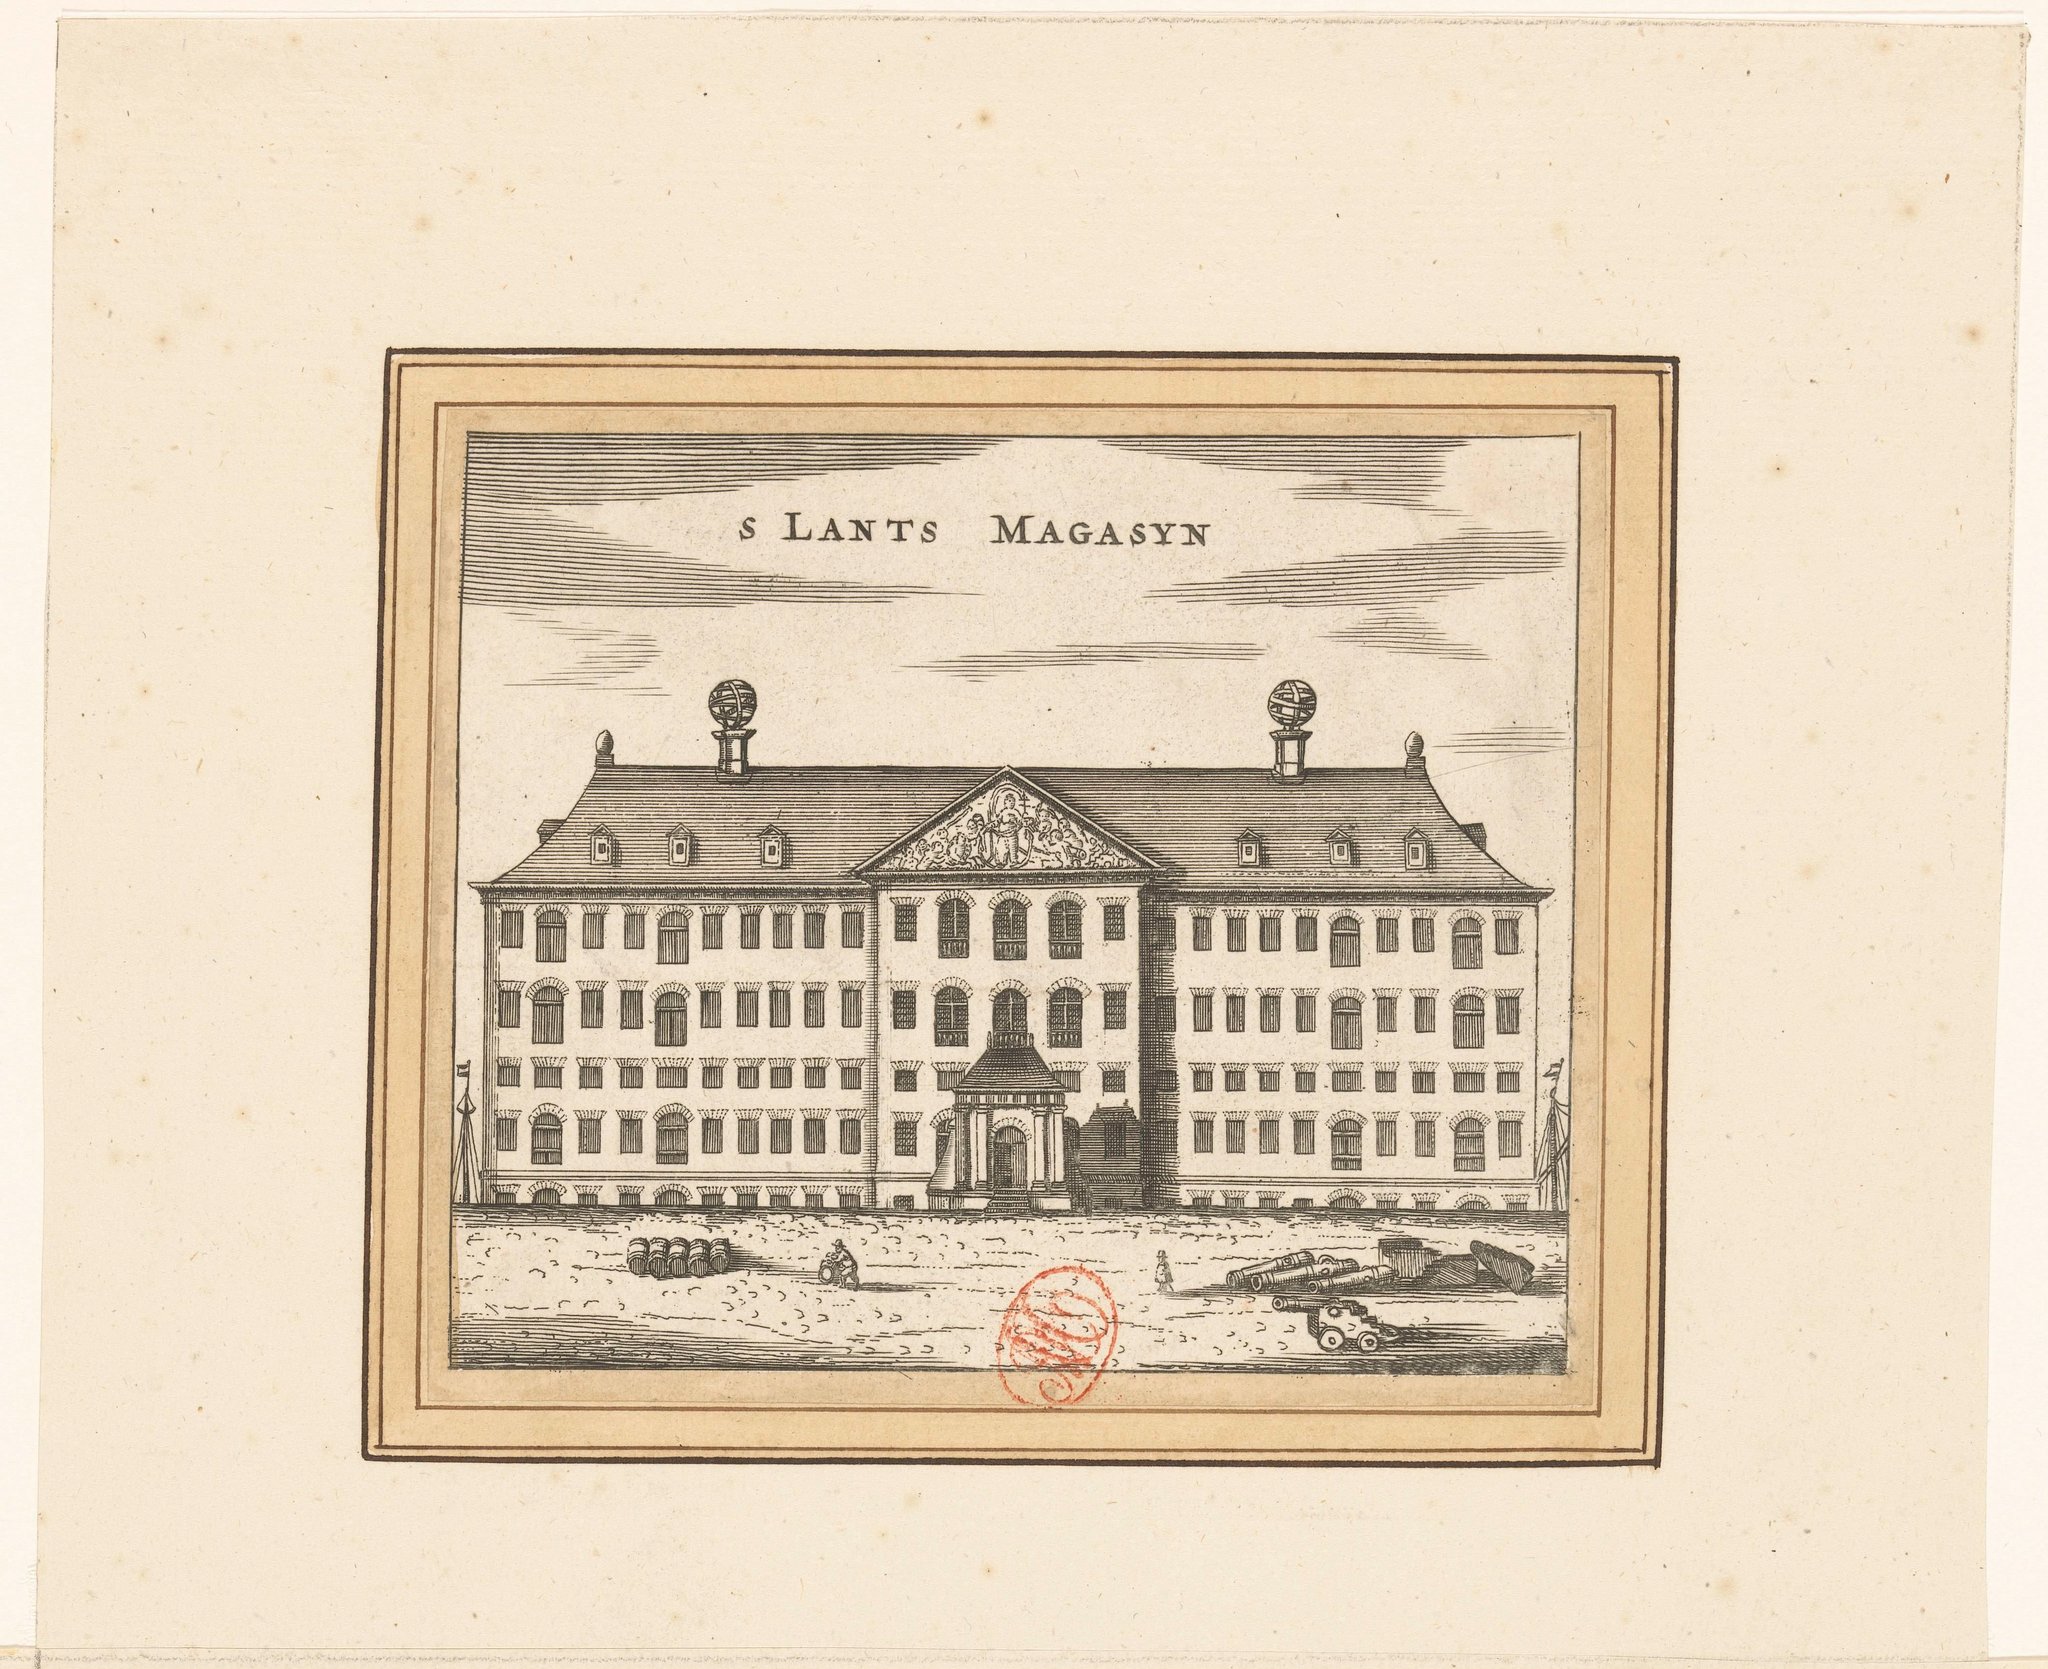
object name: book illustration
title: Gezicht op 's Lands Zeemagazijn (Admiraliteitsmagazijn) te Amsterdam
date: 1664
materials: paper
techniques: engraving, etching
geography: amsterdam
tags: large-scale structure for storage, e.g.: warehouse, depot, silo, ammunition store, arsenal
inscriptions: collector's mark: Lugt 195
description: Huidige staat van prent ook gebruikt in: Fockens, Melchior. Beschrijving Der wijdt-vermaarde Koop-stadt Amstelredam, Van haar eerste beginselen, zedert den Jare 1203. oude Voorrechten, verscheyde Vergrootingenoude Voor-rechten, en verscheyde Vergrootingen (…). 3e druk. Amsterdam: Marcus Willemsz. Doornick, 1664. En in: Zesen, Philipp von. Beschrybung der Weidtberuhmde Kauf-Stadt Amstelredam / Beschreibung der Stadt Amsterdam darinnen von derselben ersten ursprunge bis auf gegenwartigen zustand (…). Amsterdam: Marcus Willemsz. Doornick, 1664. Eerste bekende staat van prent (rechtsboven genummerd: 178) ook gebruikt in: Fockens, Melchior. Beschrijvinge Der wijdt-vermaarde Koop-stadt Amstelredam, Van hare eerste beginselen, oude Voor-rechten, en verscheyde Vergrootingen (…). 1e druk. Amsterdam: Marcus Willemsz. Doornick, 1662. En in: Fockens, Melchior. Beschrijvinge Der wijdt-vermaarde Koop-stadt Amstelredam, Van hare eerste beginselen, oude Voor-rechten, en verscheyde Vergrootingen (…). 2e druk. Amsterdam: Marcus Willemsz. Doornick, 1662. Derde bekende staat (met toevoeging Franse titel) ook gebruikt in: Domselaer, Tobias en Isaac Commelin. Beschryvinge van Amsterdam : haar eerste oorspronk uyt den huyze der heeren van Aemstel en Aemstellant (…). 6 delen. Amsterdam: Marcus Willemsz van Doornick, 1665. Vierde bekende staat (rechtsboven genummerd: 52) ook gebruikt in verschillende latere zeventiende- en achttiende-eeuwse publicaties.